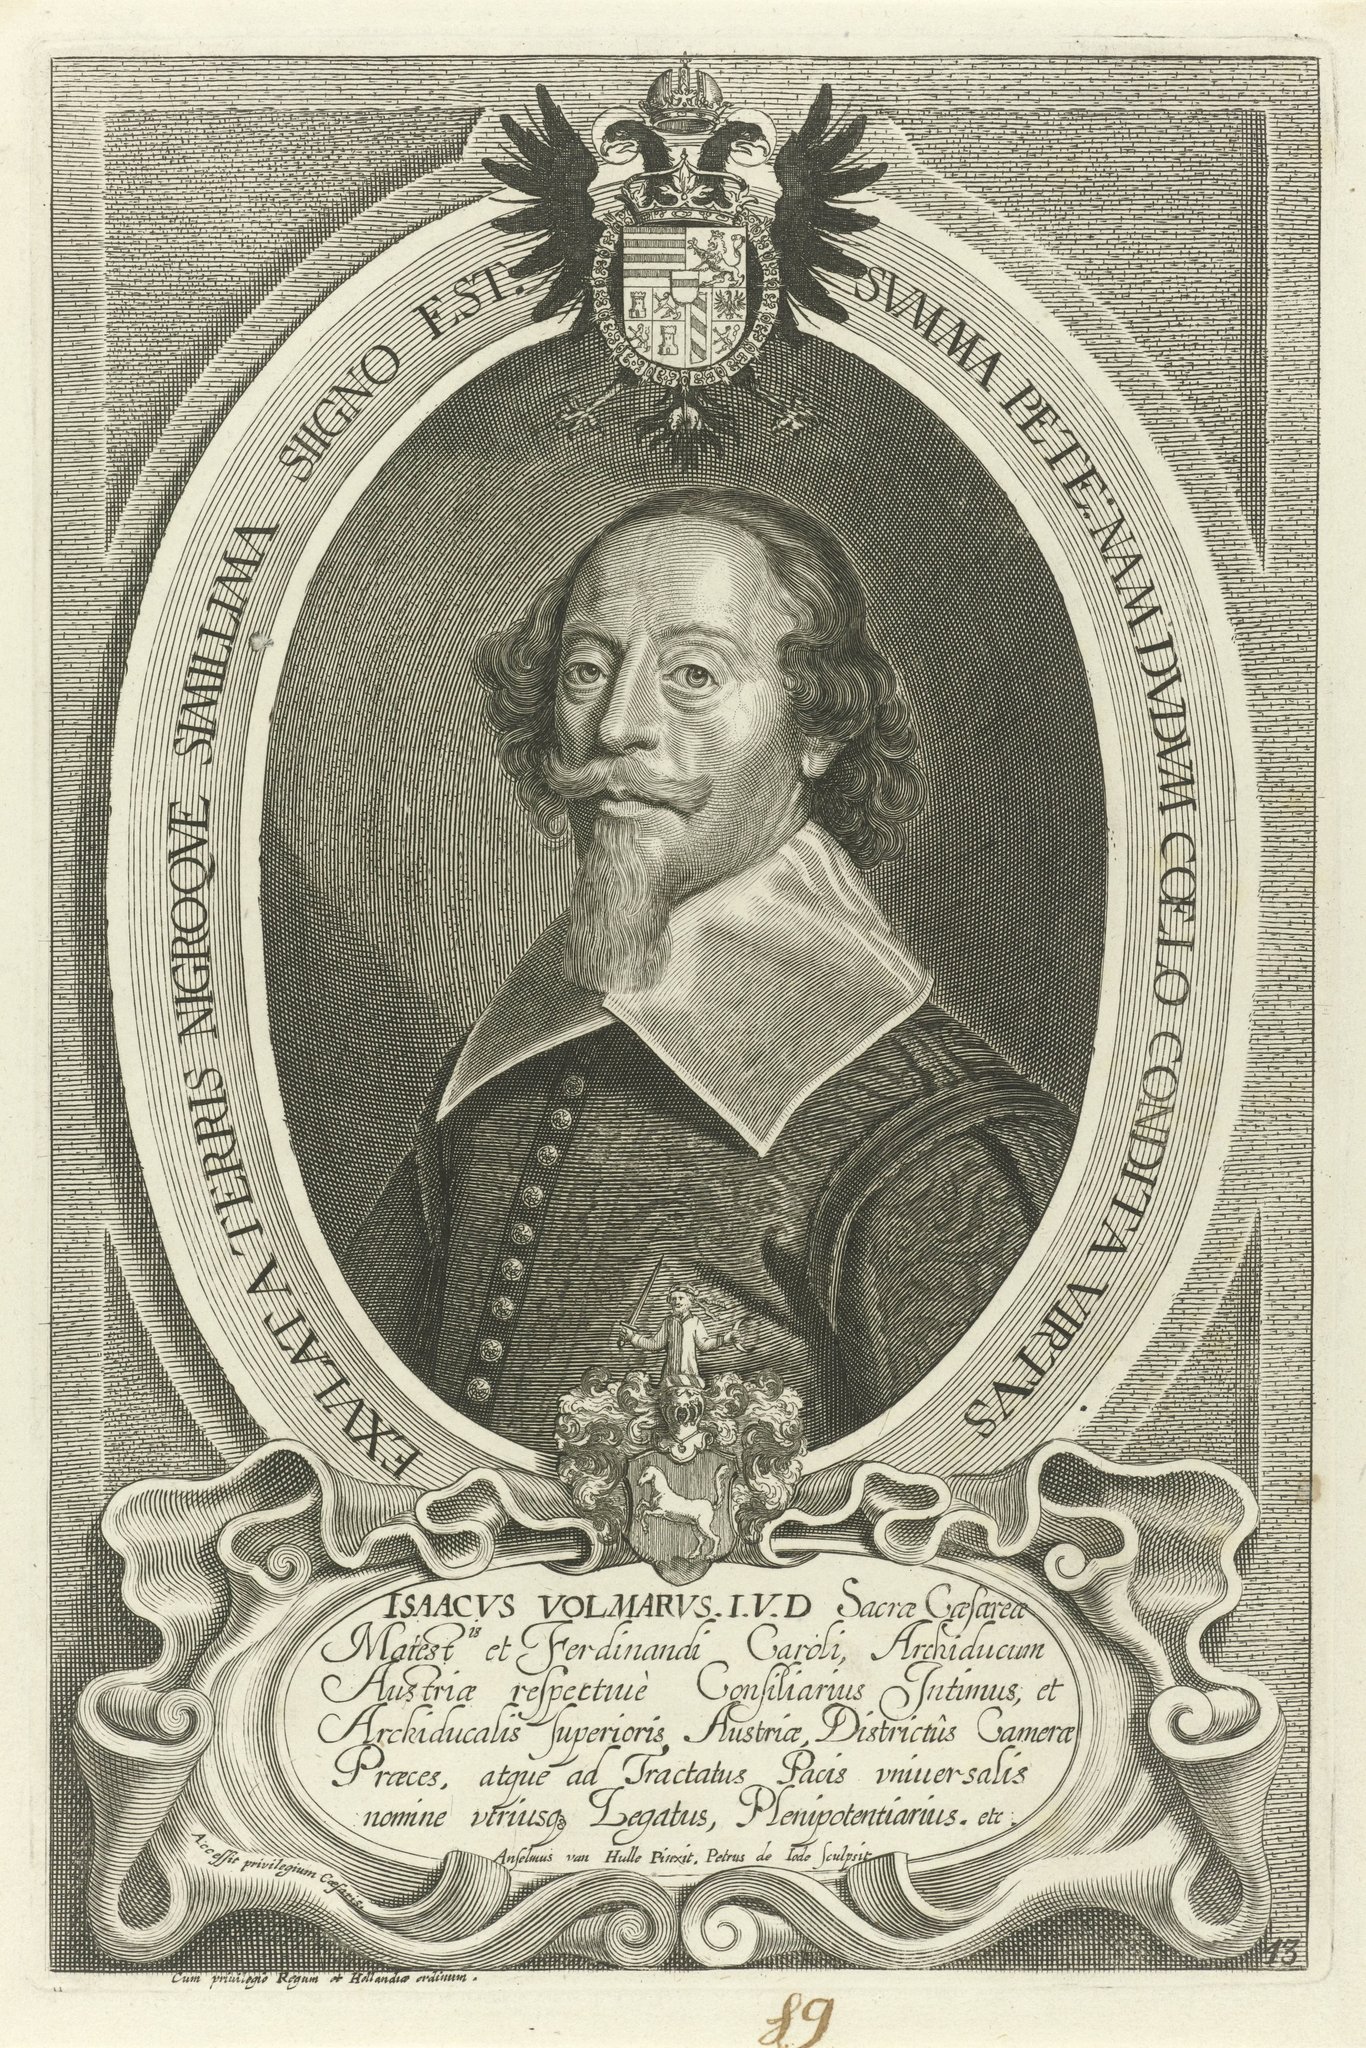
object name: print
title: Hommes illustres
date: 1628-1670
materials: paper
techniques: engraving, etching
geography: antwerp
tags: politician, knighthood order of the golden fleece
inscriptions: inscription: ‘f9’, collector's mark: Lugt 2228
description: Busteportret van Isaak Volmar. Rechtsonder: 43. Het portret is gevat in een ovale omlijsting met het wapenschild van de geportretteerde, een keten met de Orde van het Gulden Vlies en een randschrift in het Latijn. In de cartouche een zesregelig onderschrift in het Latijn. Prent uit een serie portretten naar schilderijen van Anselmus van Hulle van alle gedelegeerden bij de vredesonderhandelingen te Münster en Osnabrück.